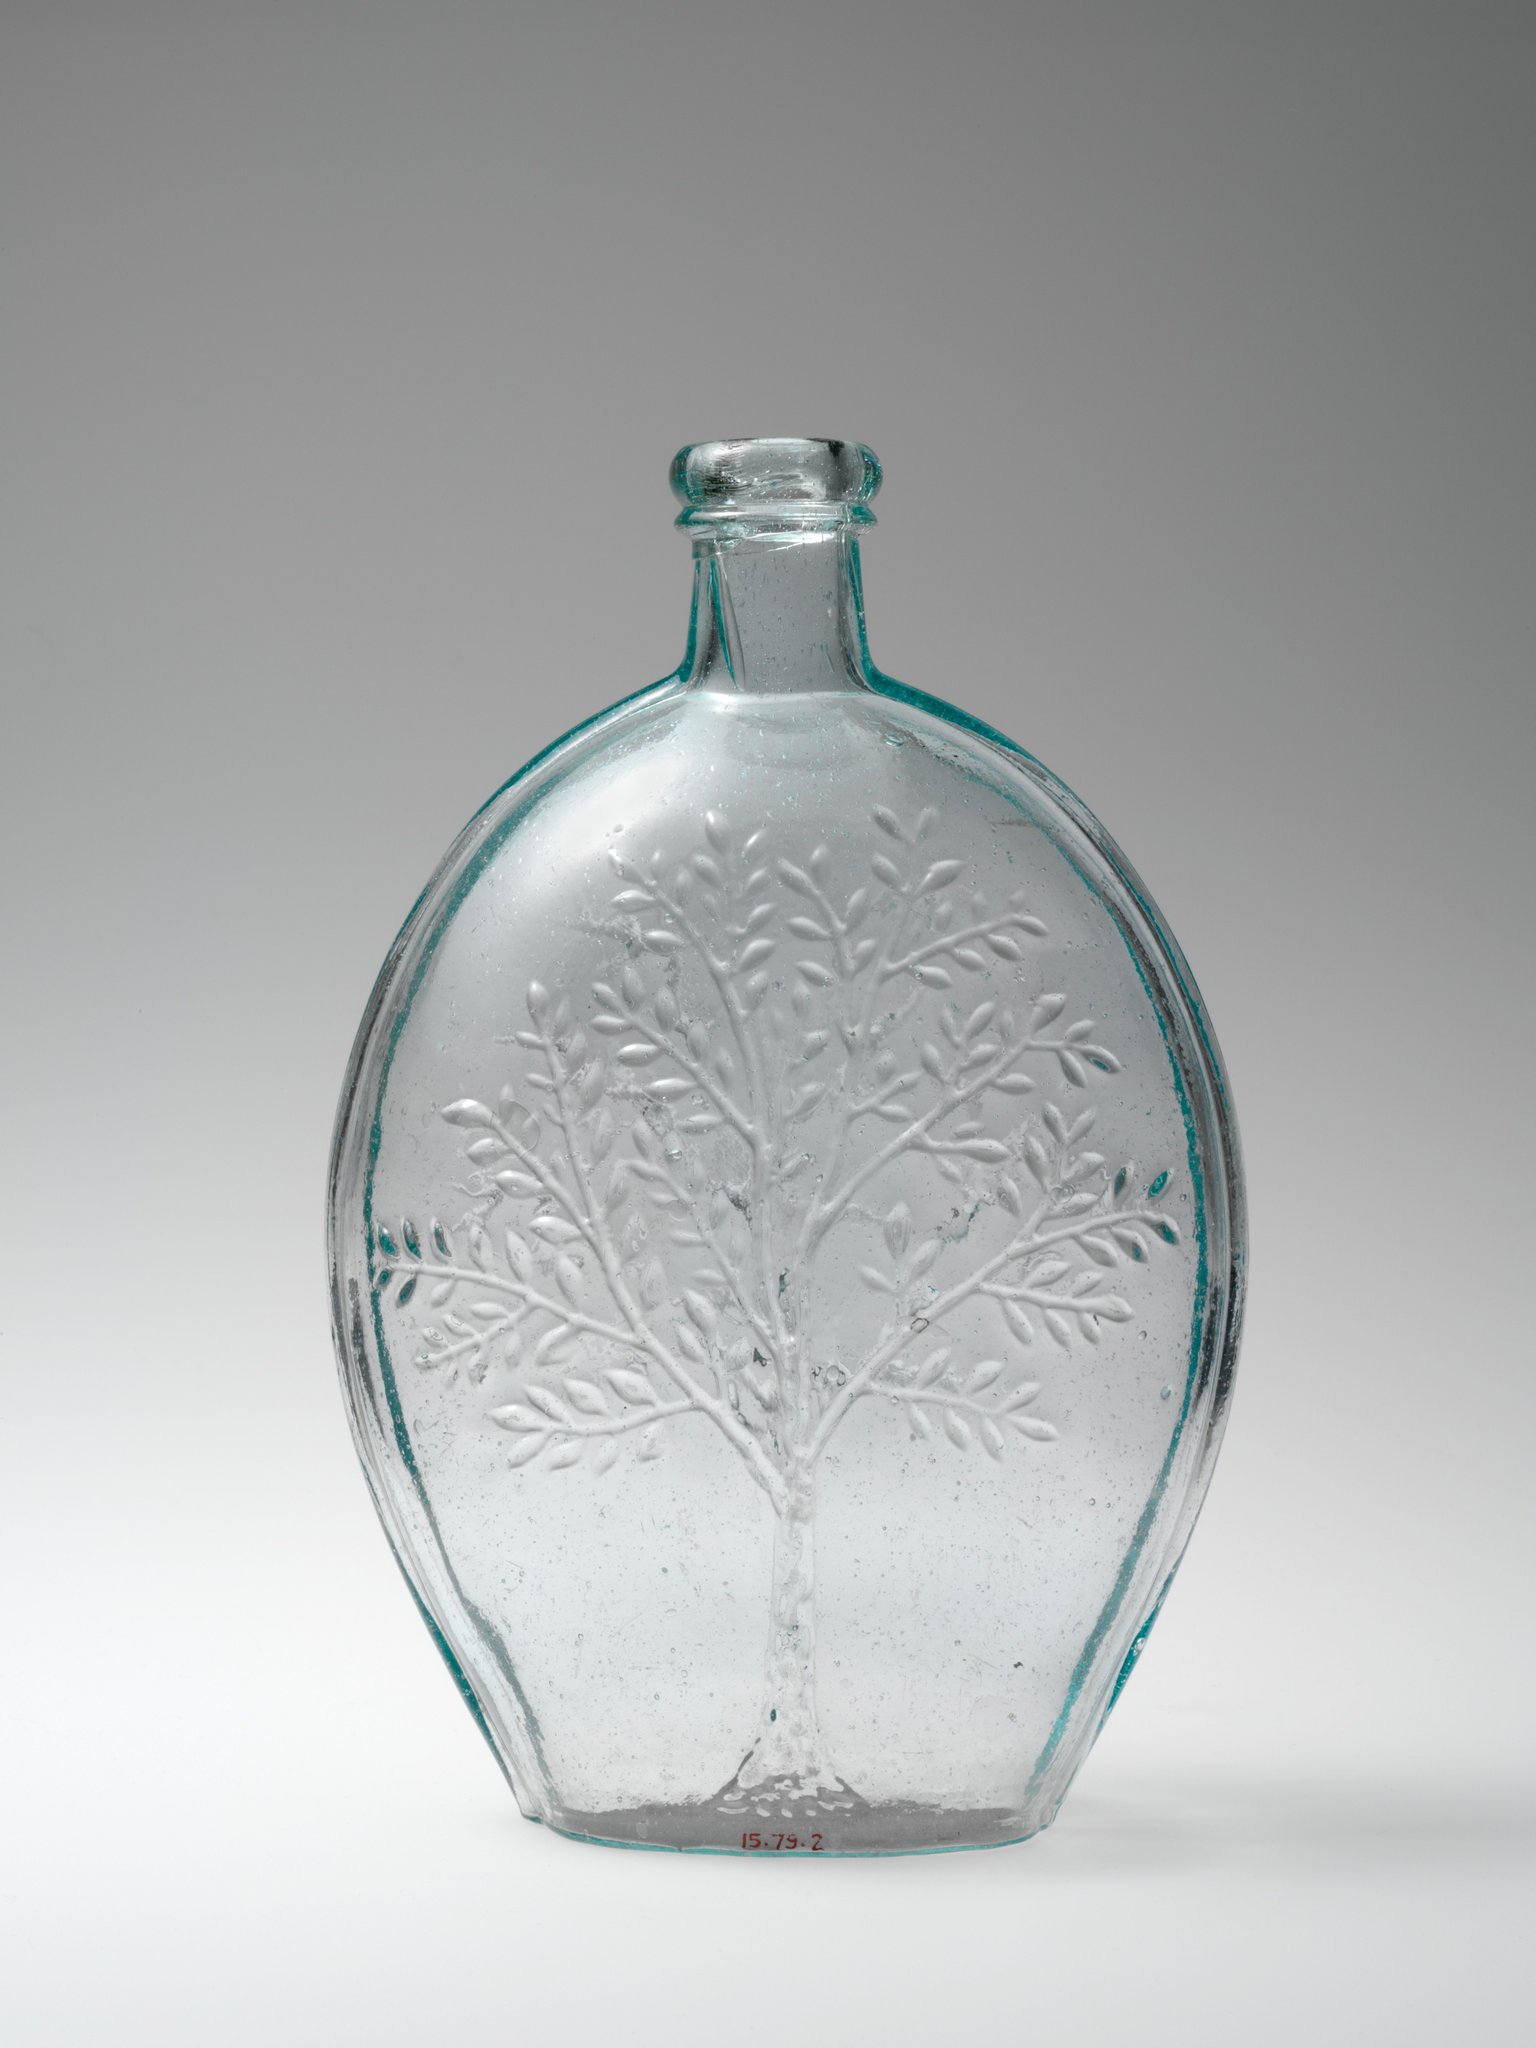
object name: flask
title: Figured flask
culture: american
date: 1835-1860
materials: glass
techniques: glassblowing, molding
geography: united states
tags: trees